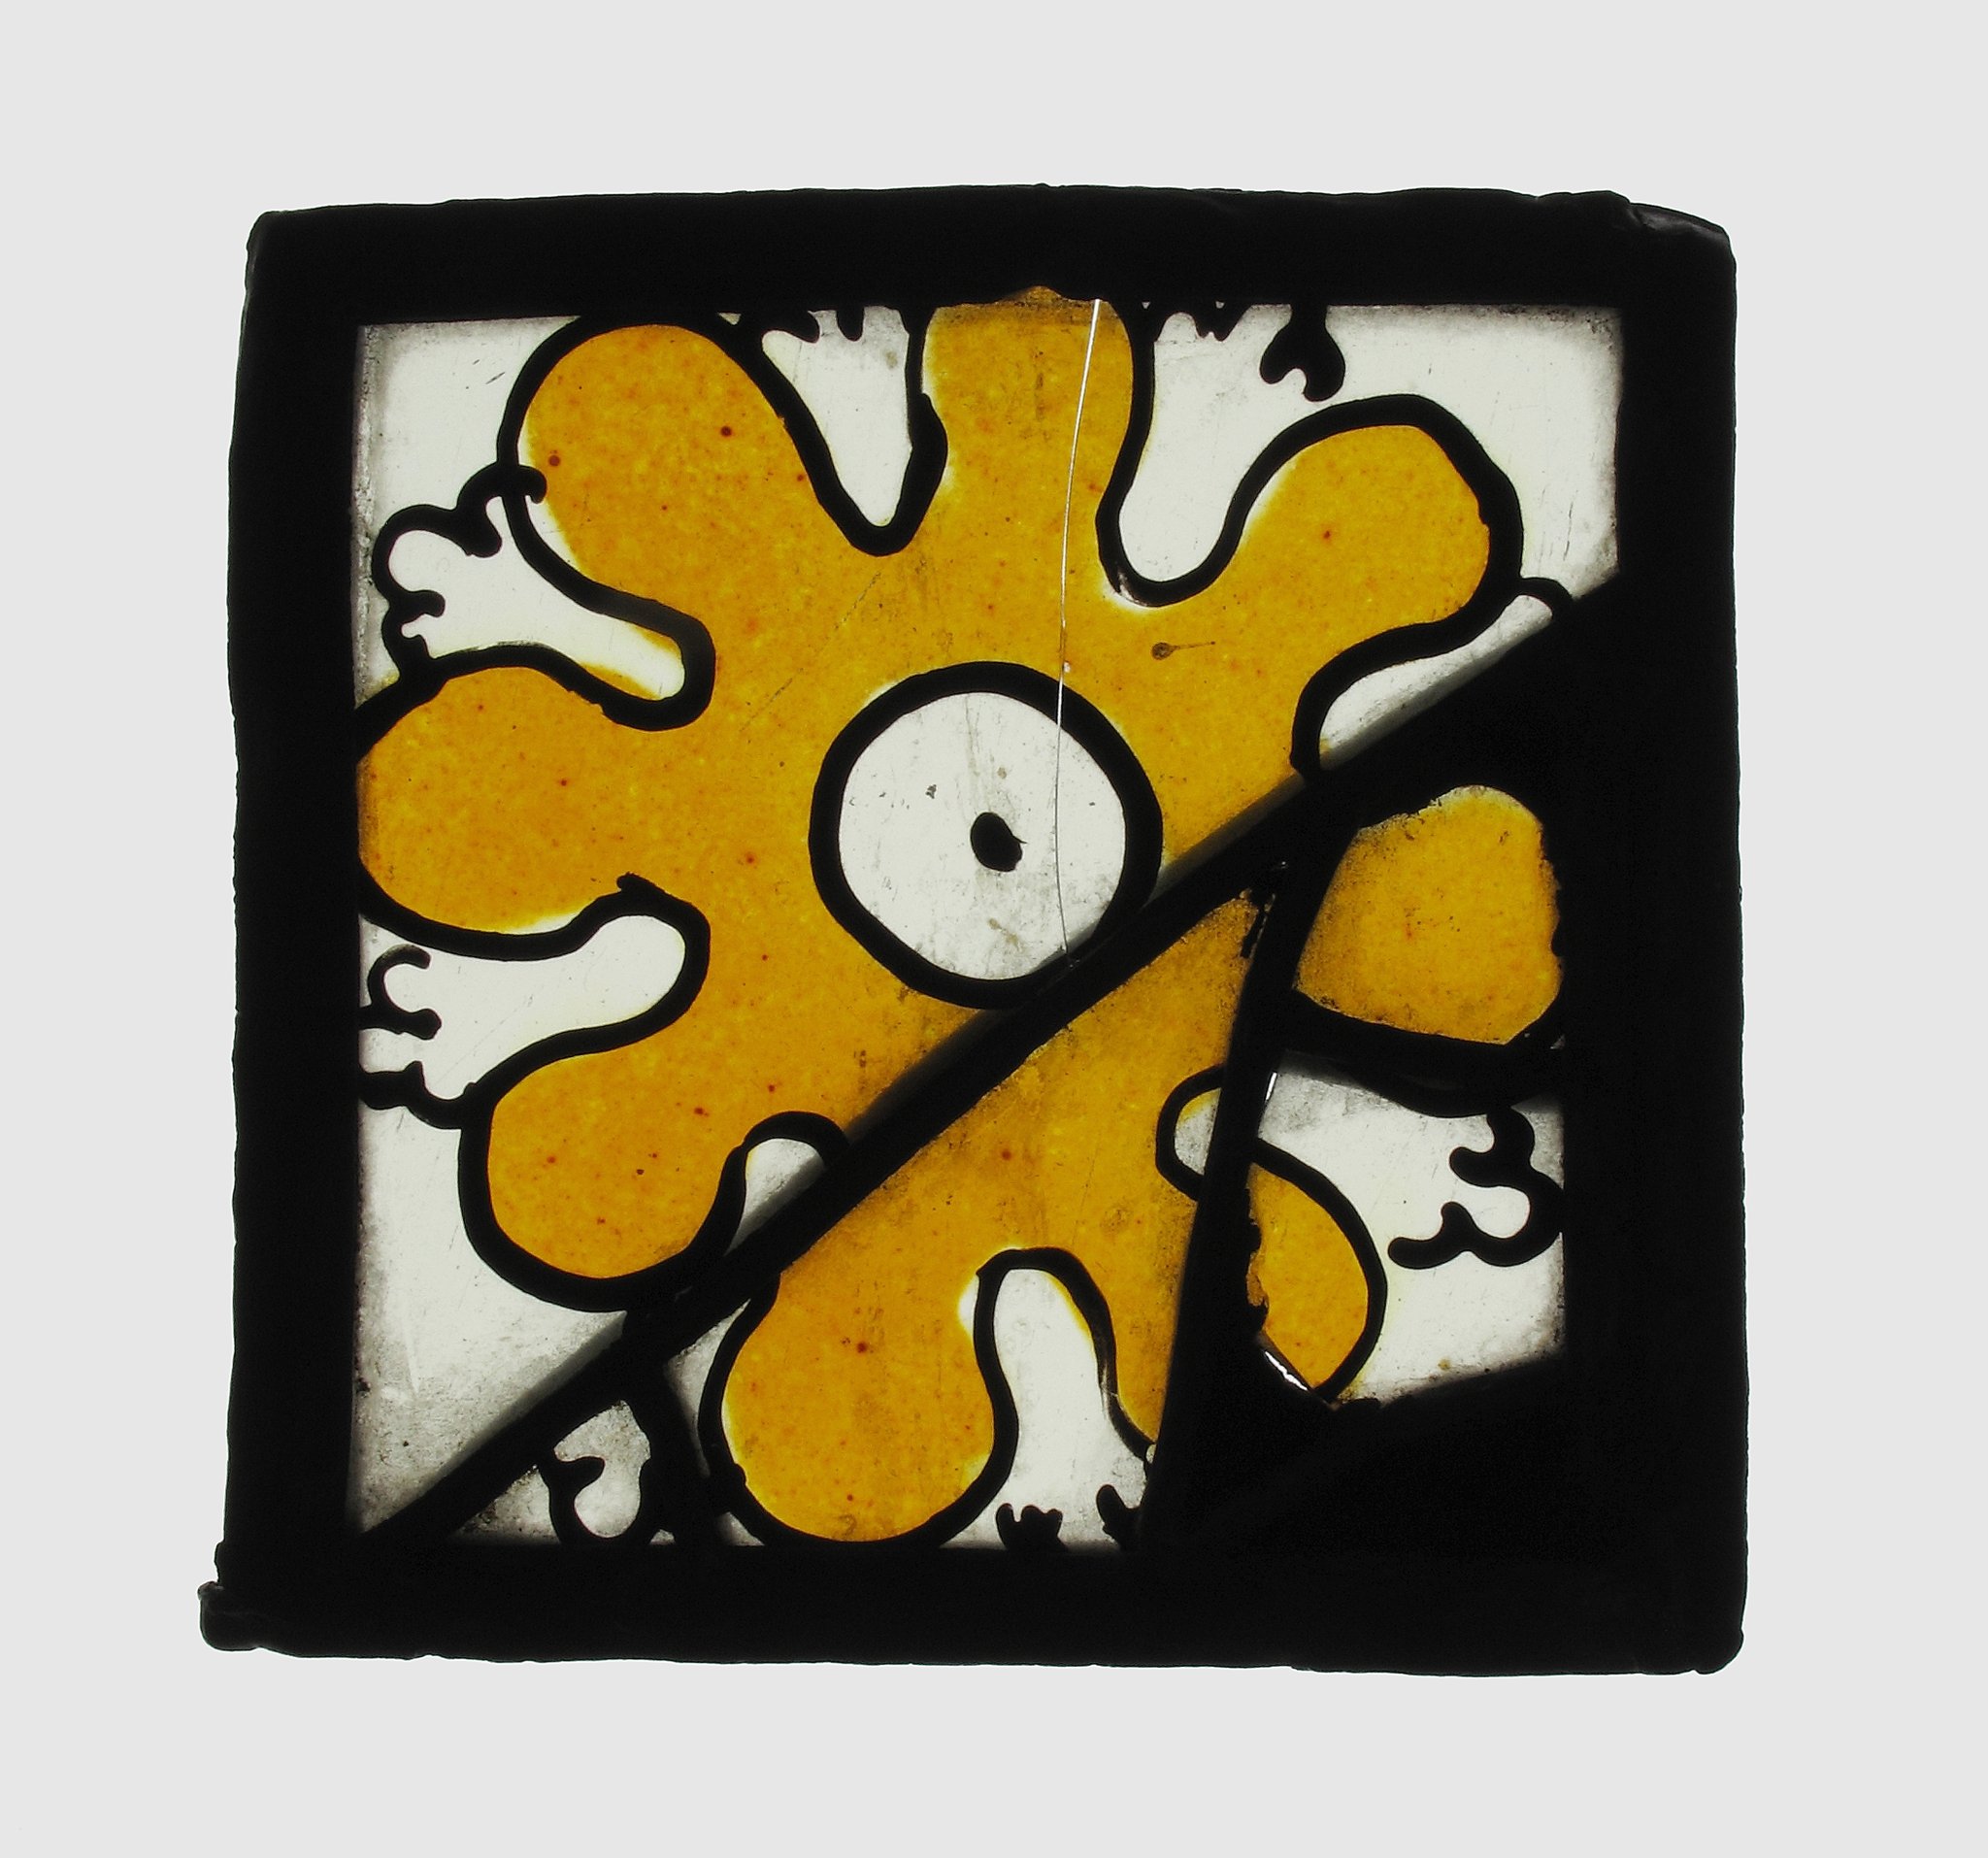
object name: fragment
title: Glass Fragment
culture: european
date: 1601-1700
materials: glass